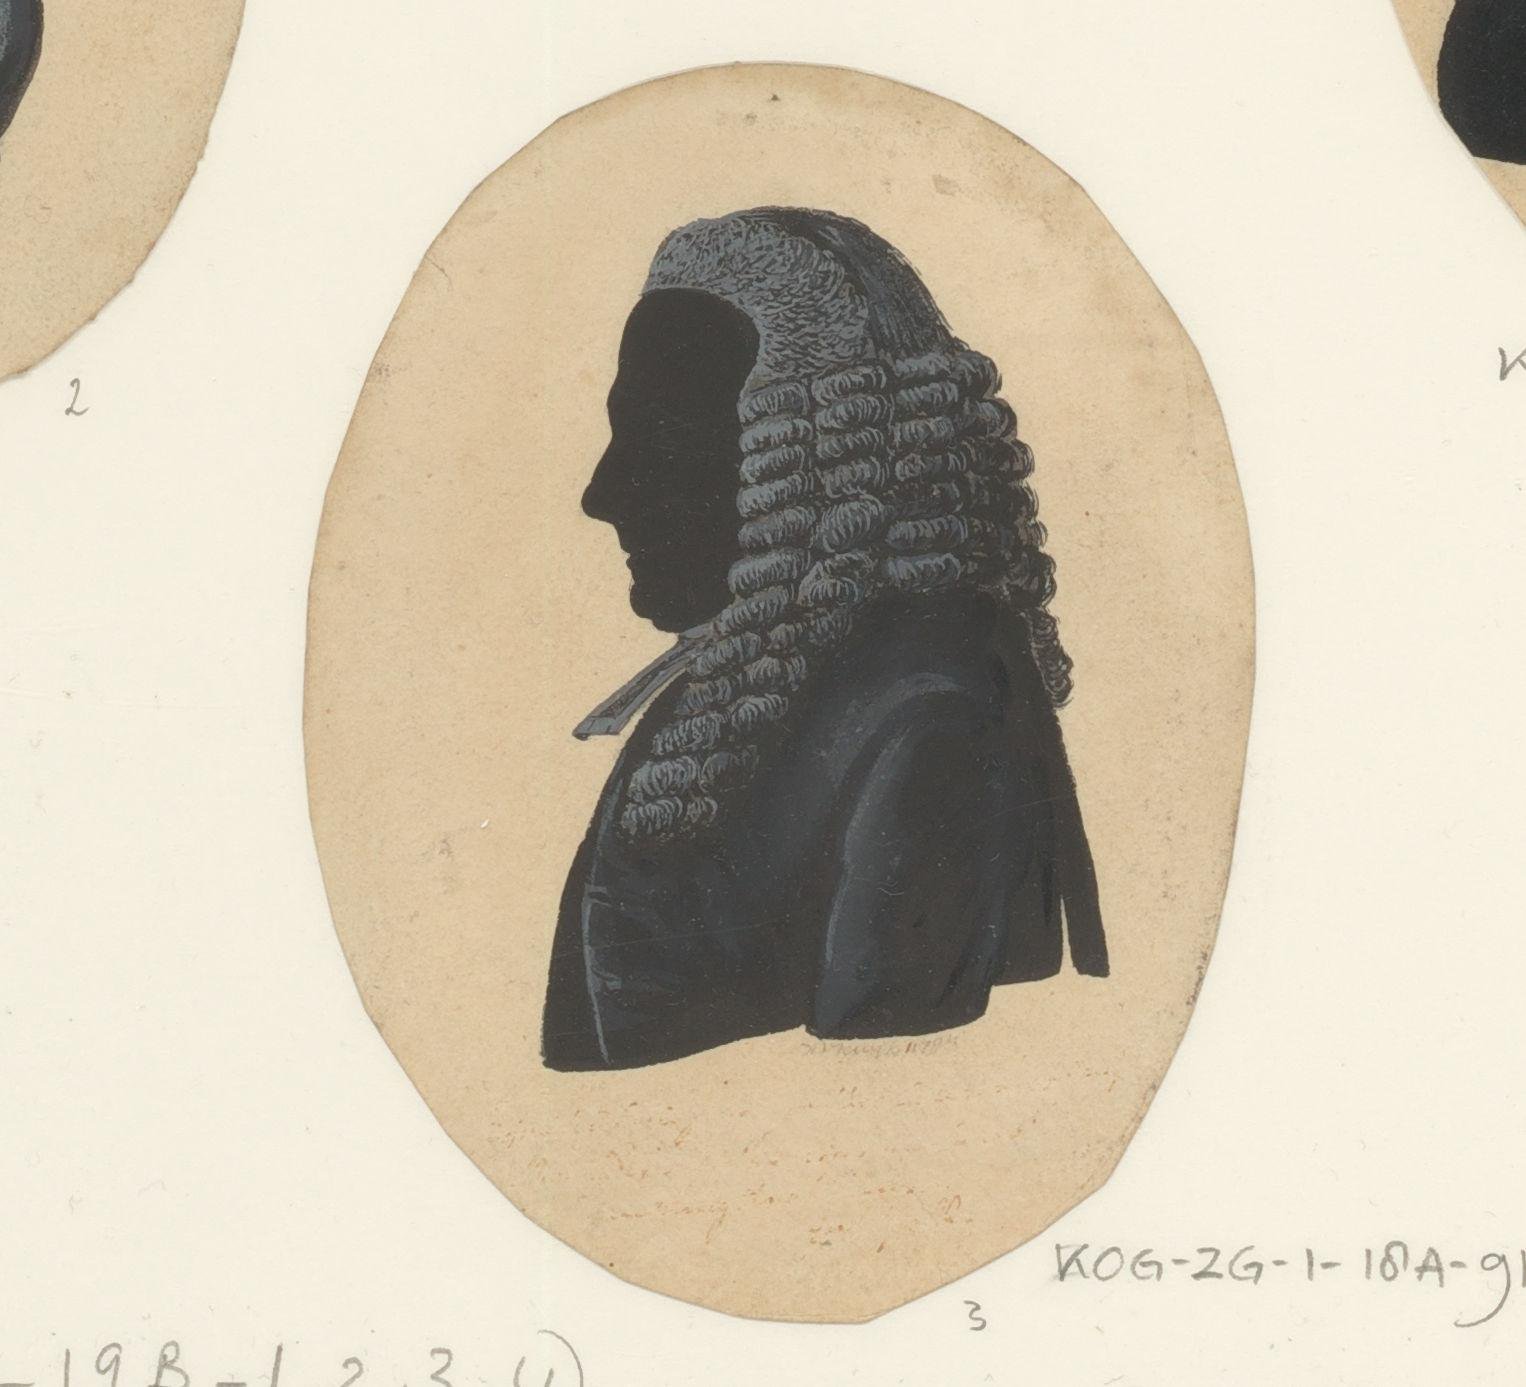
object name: drawing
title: Silhouetportret van een onbekende man met lange krullende pruik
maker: h. van kuyk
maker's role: draughtsman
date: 1794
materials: ink, paint, paper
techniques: brush, pen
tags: wig, historical persons not known by name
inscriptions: collector's mark: Lugt 1641, stamp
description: Onderwerpsrubrieken binnen de Atlas Zeden en Gewoonten: Schoone kunsten, Silhouetportretten.